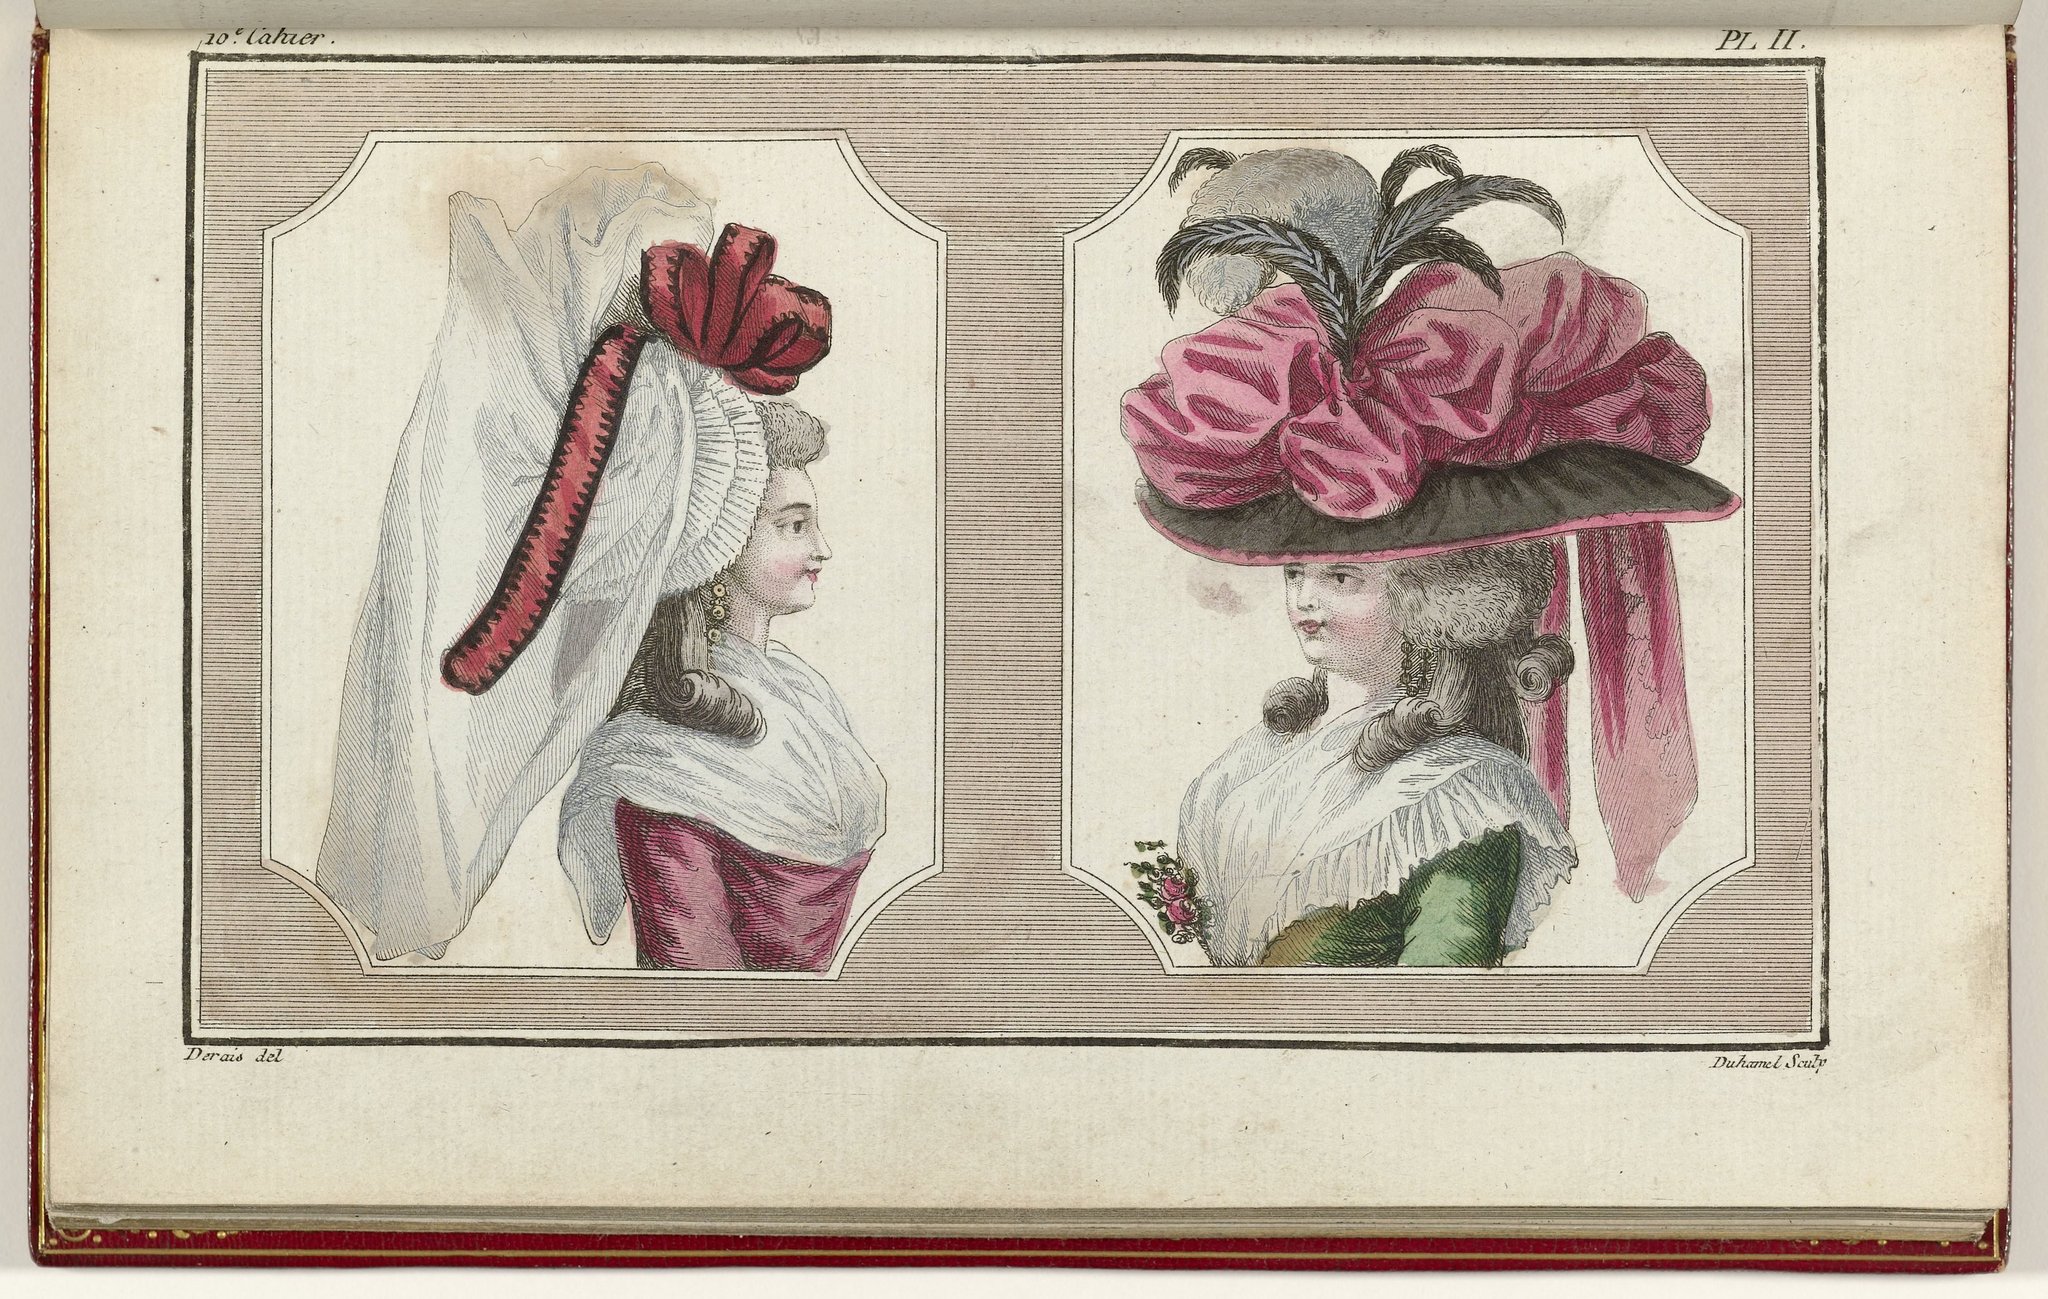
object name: fashion print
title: Cabinet des Modes ou les Modes Nouvelles, 1 Avril 1786, pl. II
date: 1786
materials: paper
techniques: engraving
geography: paris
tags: bow (ornamental part of clothing) (+ women's clothes), head-gear (baigneuse) (+ women's clothes), fashion plates, head-gear: hat (+ women's clothes)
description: Twee vrouwenbustes. De beschrijving van de begeleidende tekst luidt: de vrouw rechts draagt een appelgroene 'Pierrot' en op het hoofd een zwarte hoed 'à la Maltoise", afgezet met een lint "au diadème". Op de bol van hoed een toef roze crêpe die verscheidene strikken vormt en waarvan twee slippen tot op de schouders hangen. Versierd met een aigrette van zwarte hanenveren en een witte pluim. Over de kraag van de japon een fichu van gaze, met middenvoor een toefje rozen. Kapsel 'à la Conseillère'. Lange oorbellen 'à la plaquette`. De vrouw links is gekleed in een roze 'Pierrot' en draagt op het hoofd een "Baigneuse" van witte gaze met een grote voile. Voor op de hoed een strik van een lint 'au diadème', waarvan de twee uiteinden tot op de schouders vallen. Over de kraag van de japon een grote halsdoek of 'Mouchoir' van gaze. Lange oorbellen 'à la plaquette'. Kapsel met een platte chignon op het achterhoofd en een lange krul die op de borst valt.